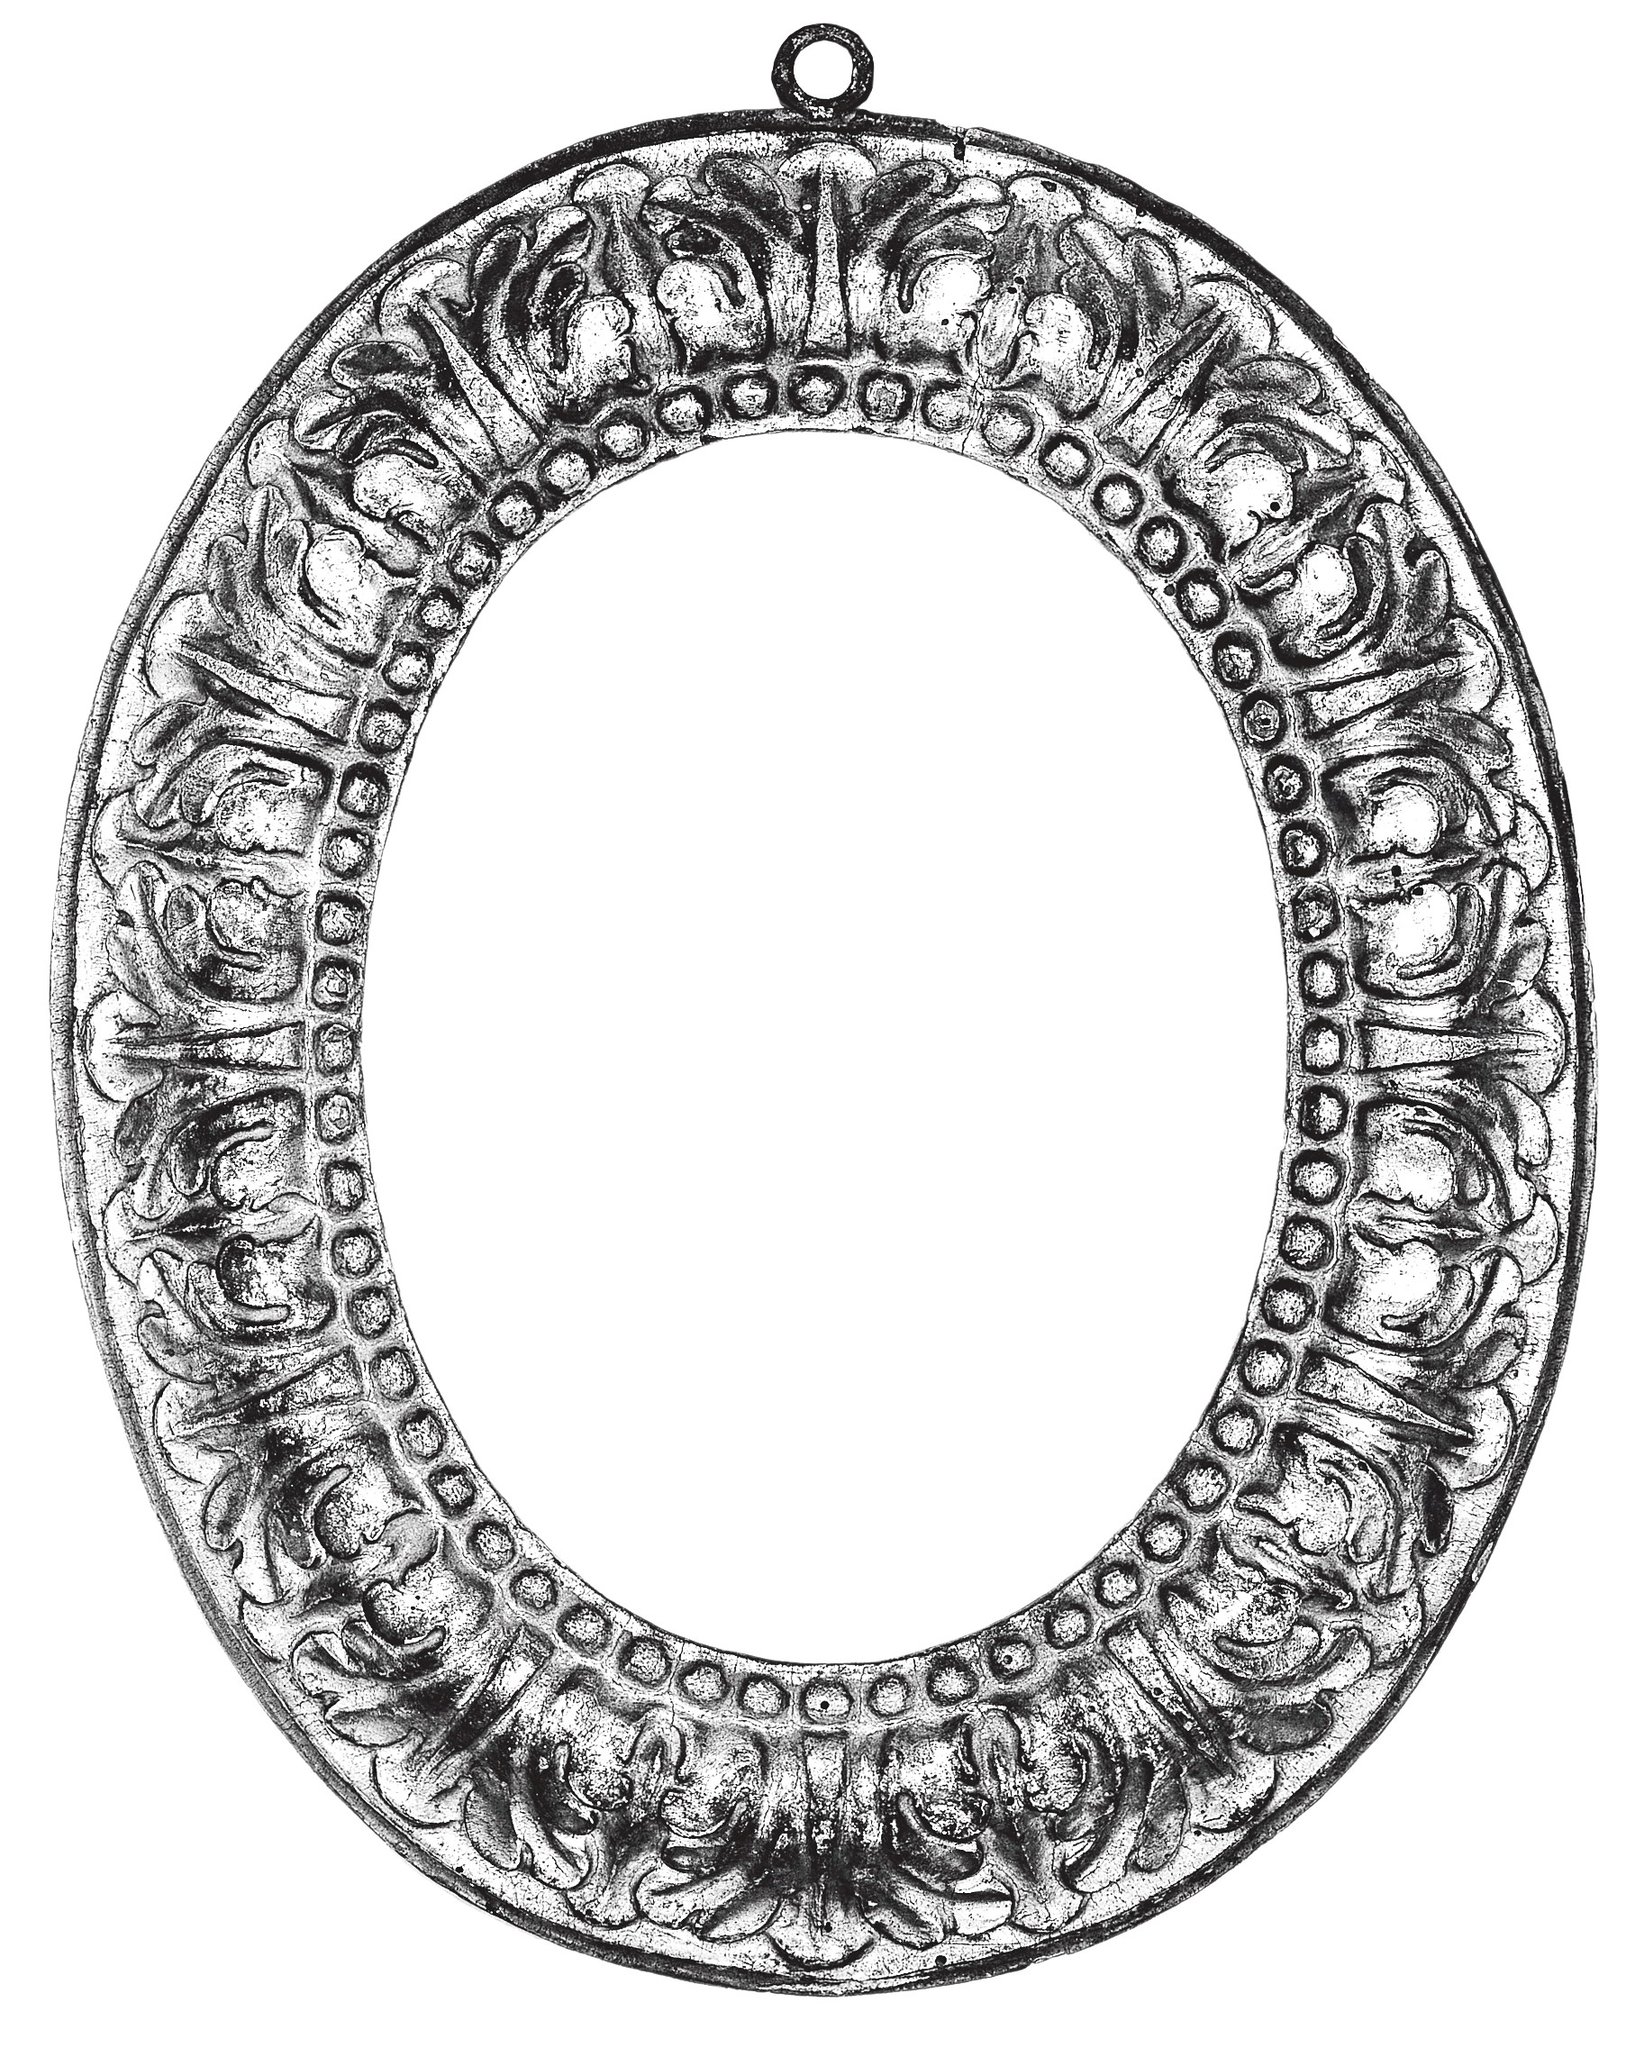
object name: frame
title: Reverse ogee frame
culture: southern italian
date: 1634-1666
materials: wood